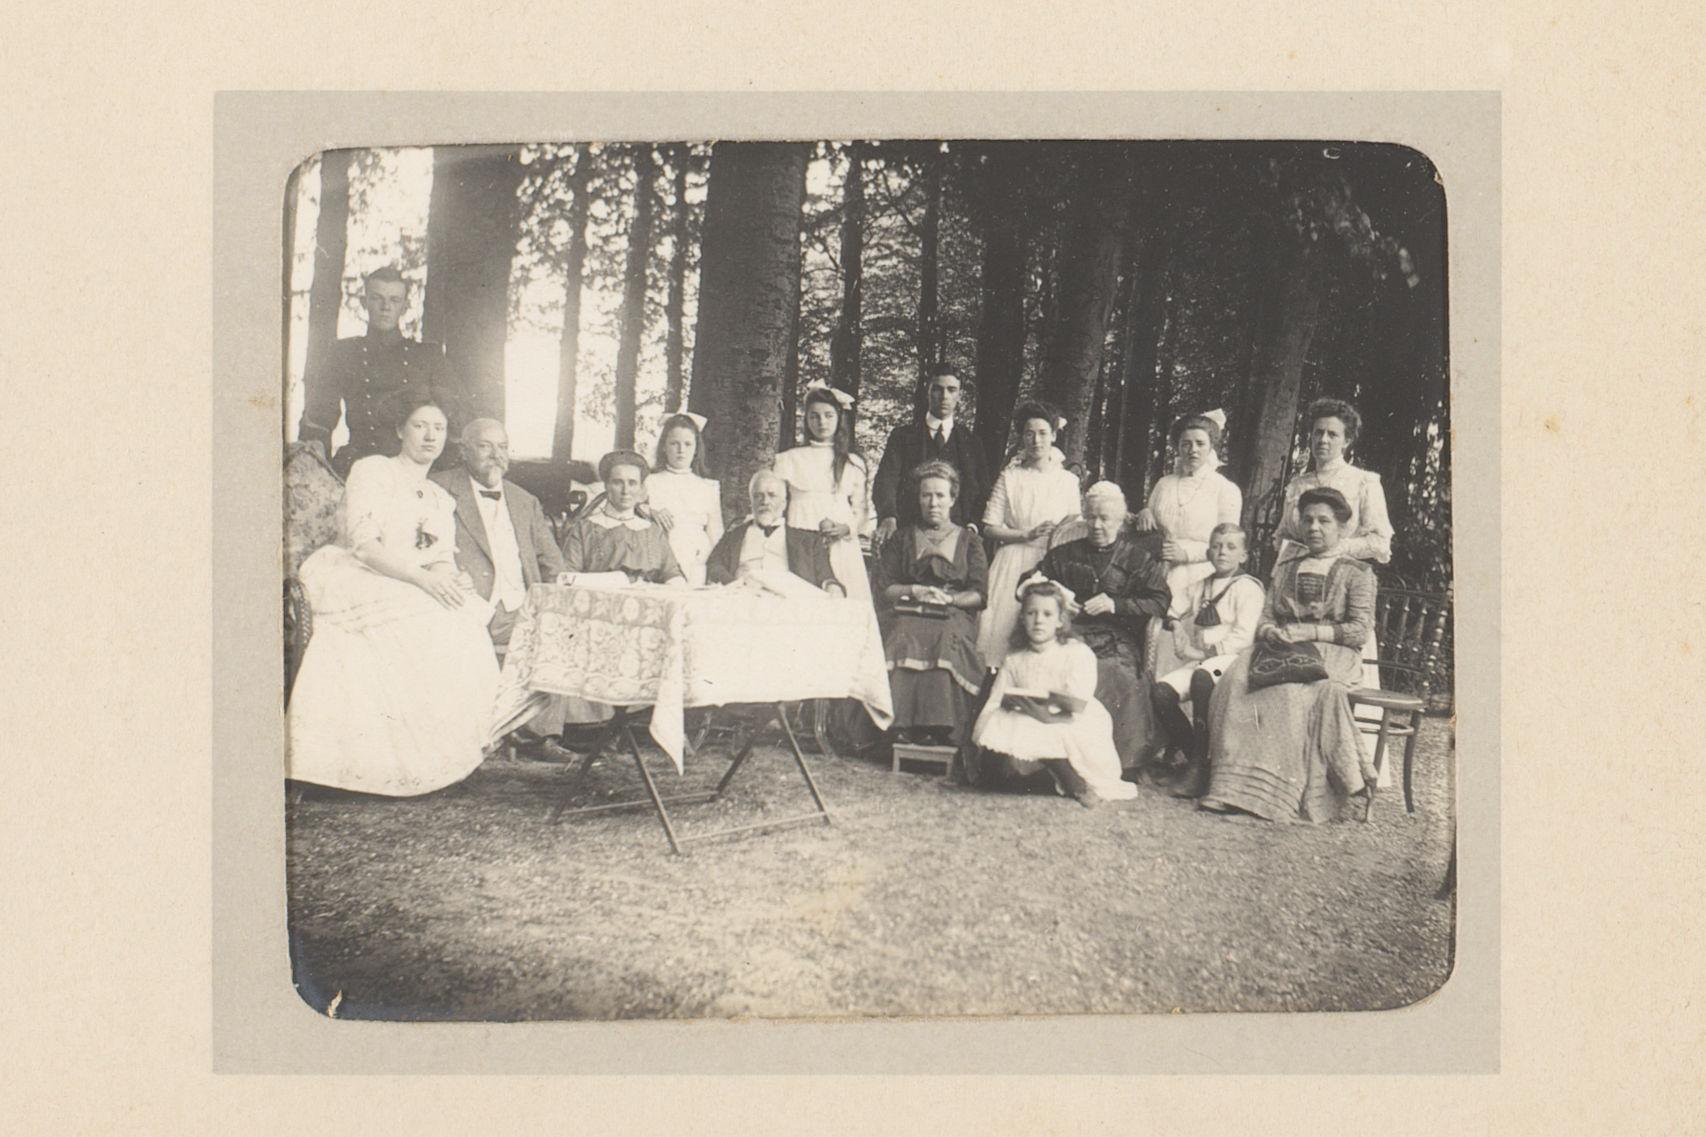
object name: album leaf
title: Groepsportret van een gezelschap rondom een tafel in de bossen bij Ellecom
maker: liesbeth overhoff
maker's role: fotograaf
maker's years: 1895-1969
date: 1911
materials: paper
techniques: gelatin silver print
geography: ellecom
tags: midday meal, lunch - cc - out of doors, forest, wood, anonymous historical persons portrayed in a group, in a group-portrait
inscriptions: inscription: ‘Ellecom 1911.’